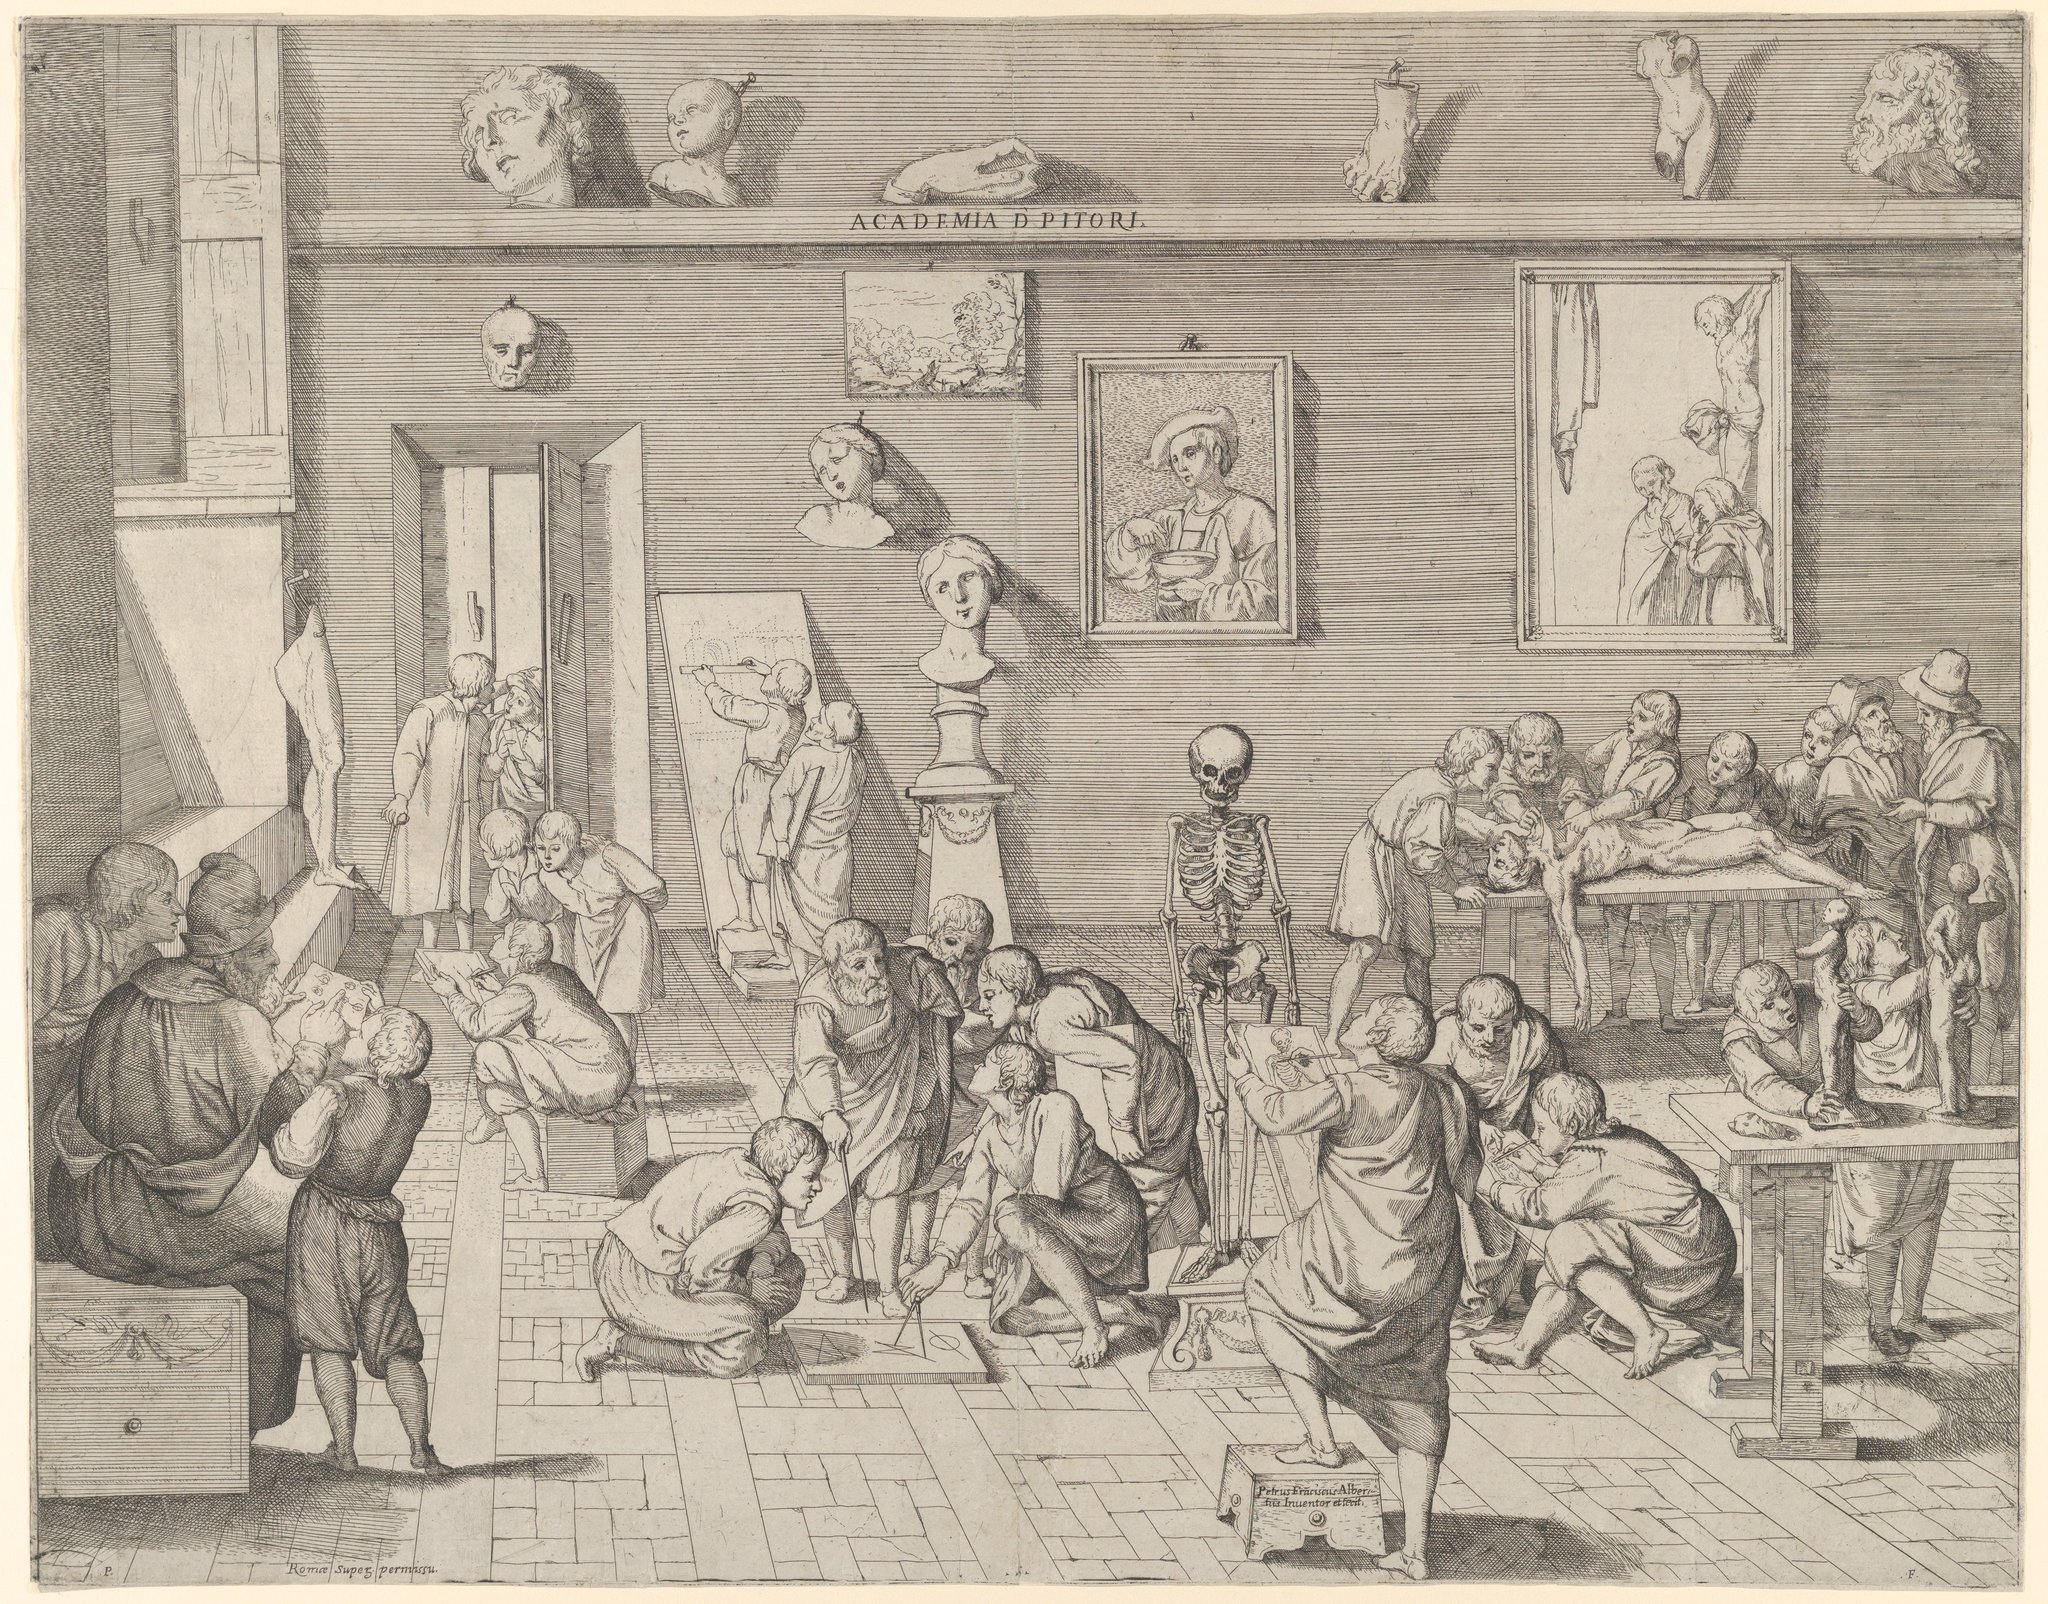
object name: print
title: An Academy of Painters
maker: pierfrancesco alberti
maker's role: artist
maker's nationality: italian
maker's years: 1584-1638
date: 1600-1638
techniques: etching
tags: painting,sculpture,skeletons,men,women